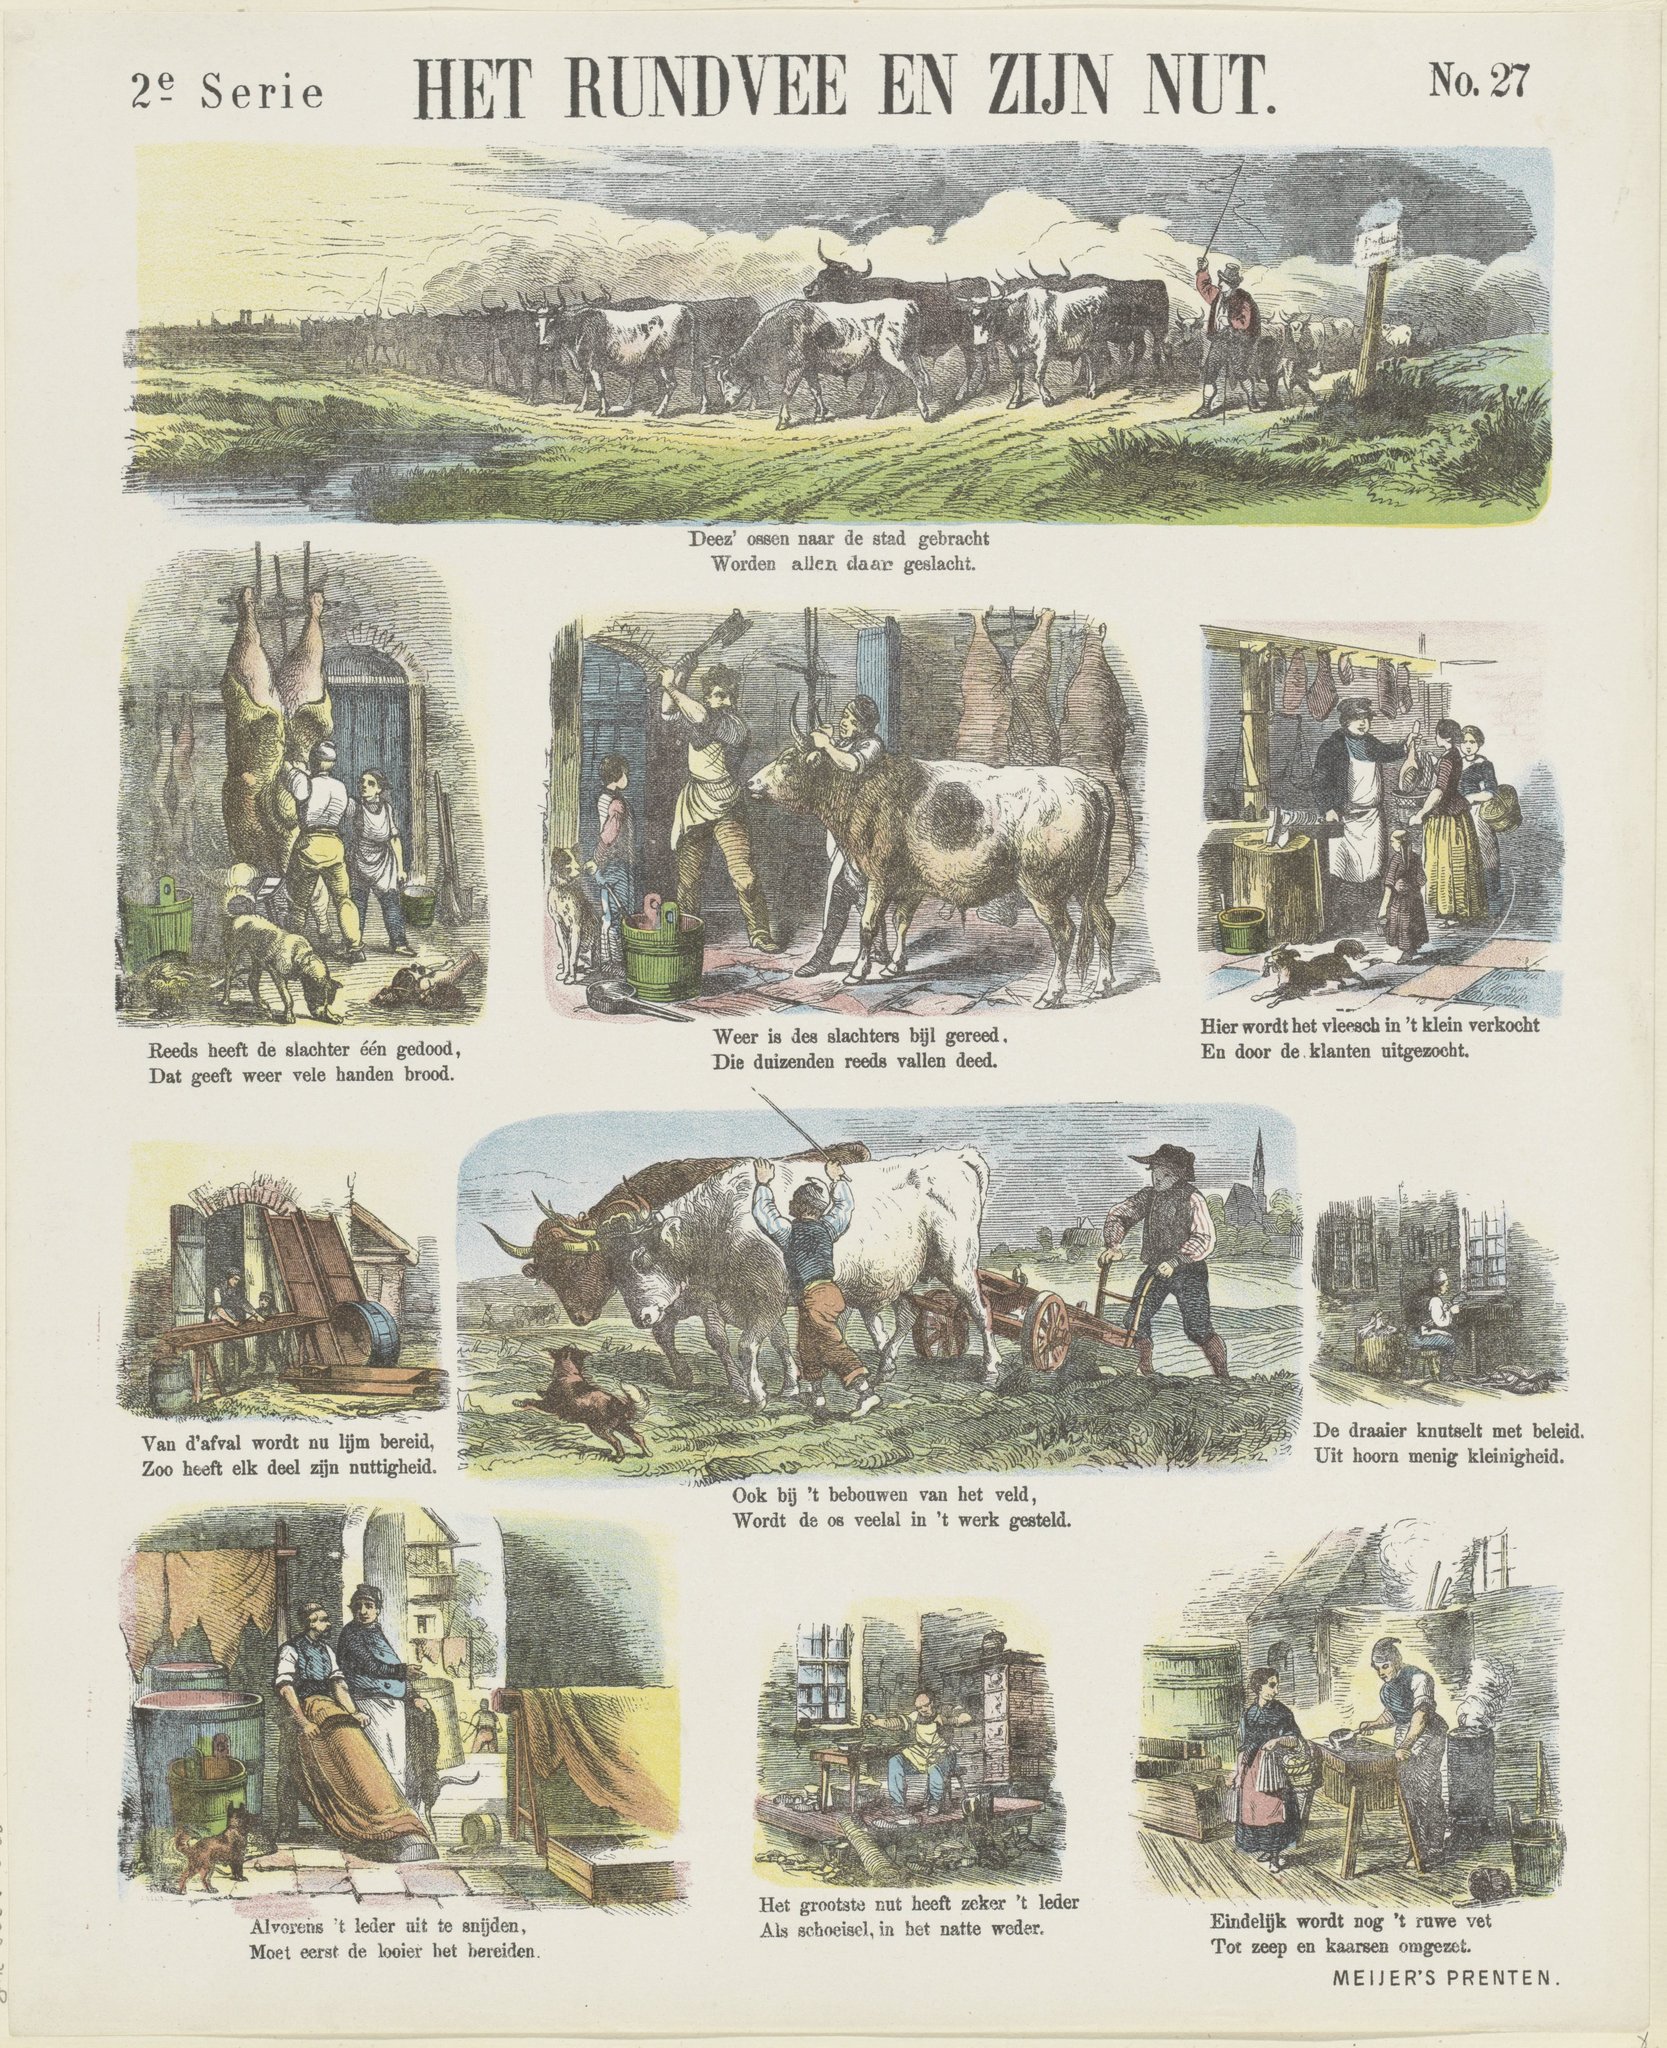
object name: print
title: Meijer's prenten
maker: Anonymous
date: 1874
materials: paper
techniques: lithograph, letterpress printing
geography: amsterdam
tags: cow, other handicrafts ~ leather, cattle driving, cattle driver, butcher, slaughterman, ox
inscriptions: collector's mark: Lugt 2760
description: Blad met 10 voorstellingen over het houden van rundvee en hun nut, waaronder voorstellingen van veedrijven, de slachter, vleesverkoop, lijm bereiden, ploegen, hoorn bewerker, leerlooier, schoenmaker en zeepzieder. Onder elke afbeelding een tweeregelig vers. Genummerd rechtsboven: No. 27.